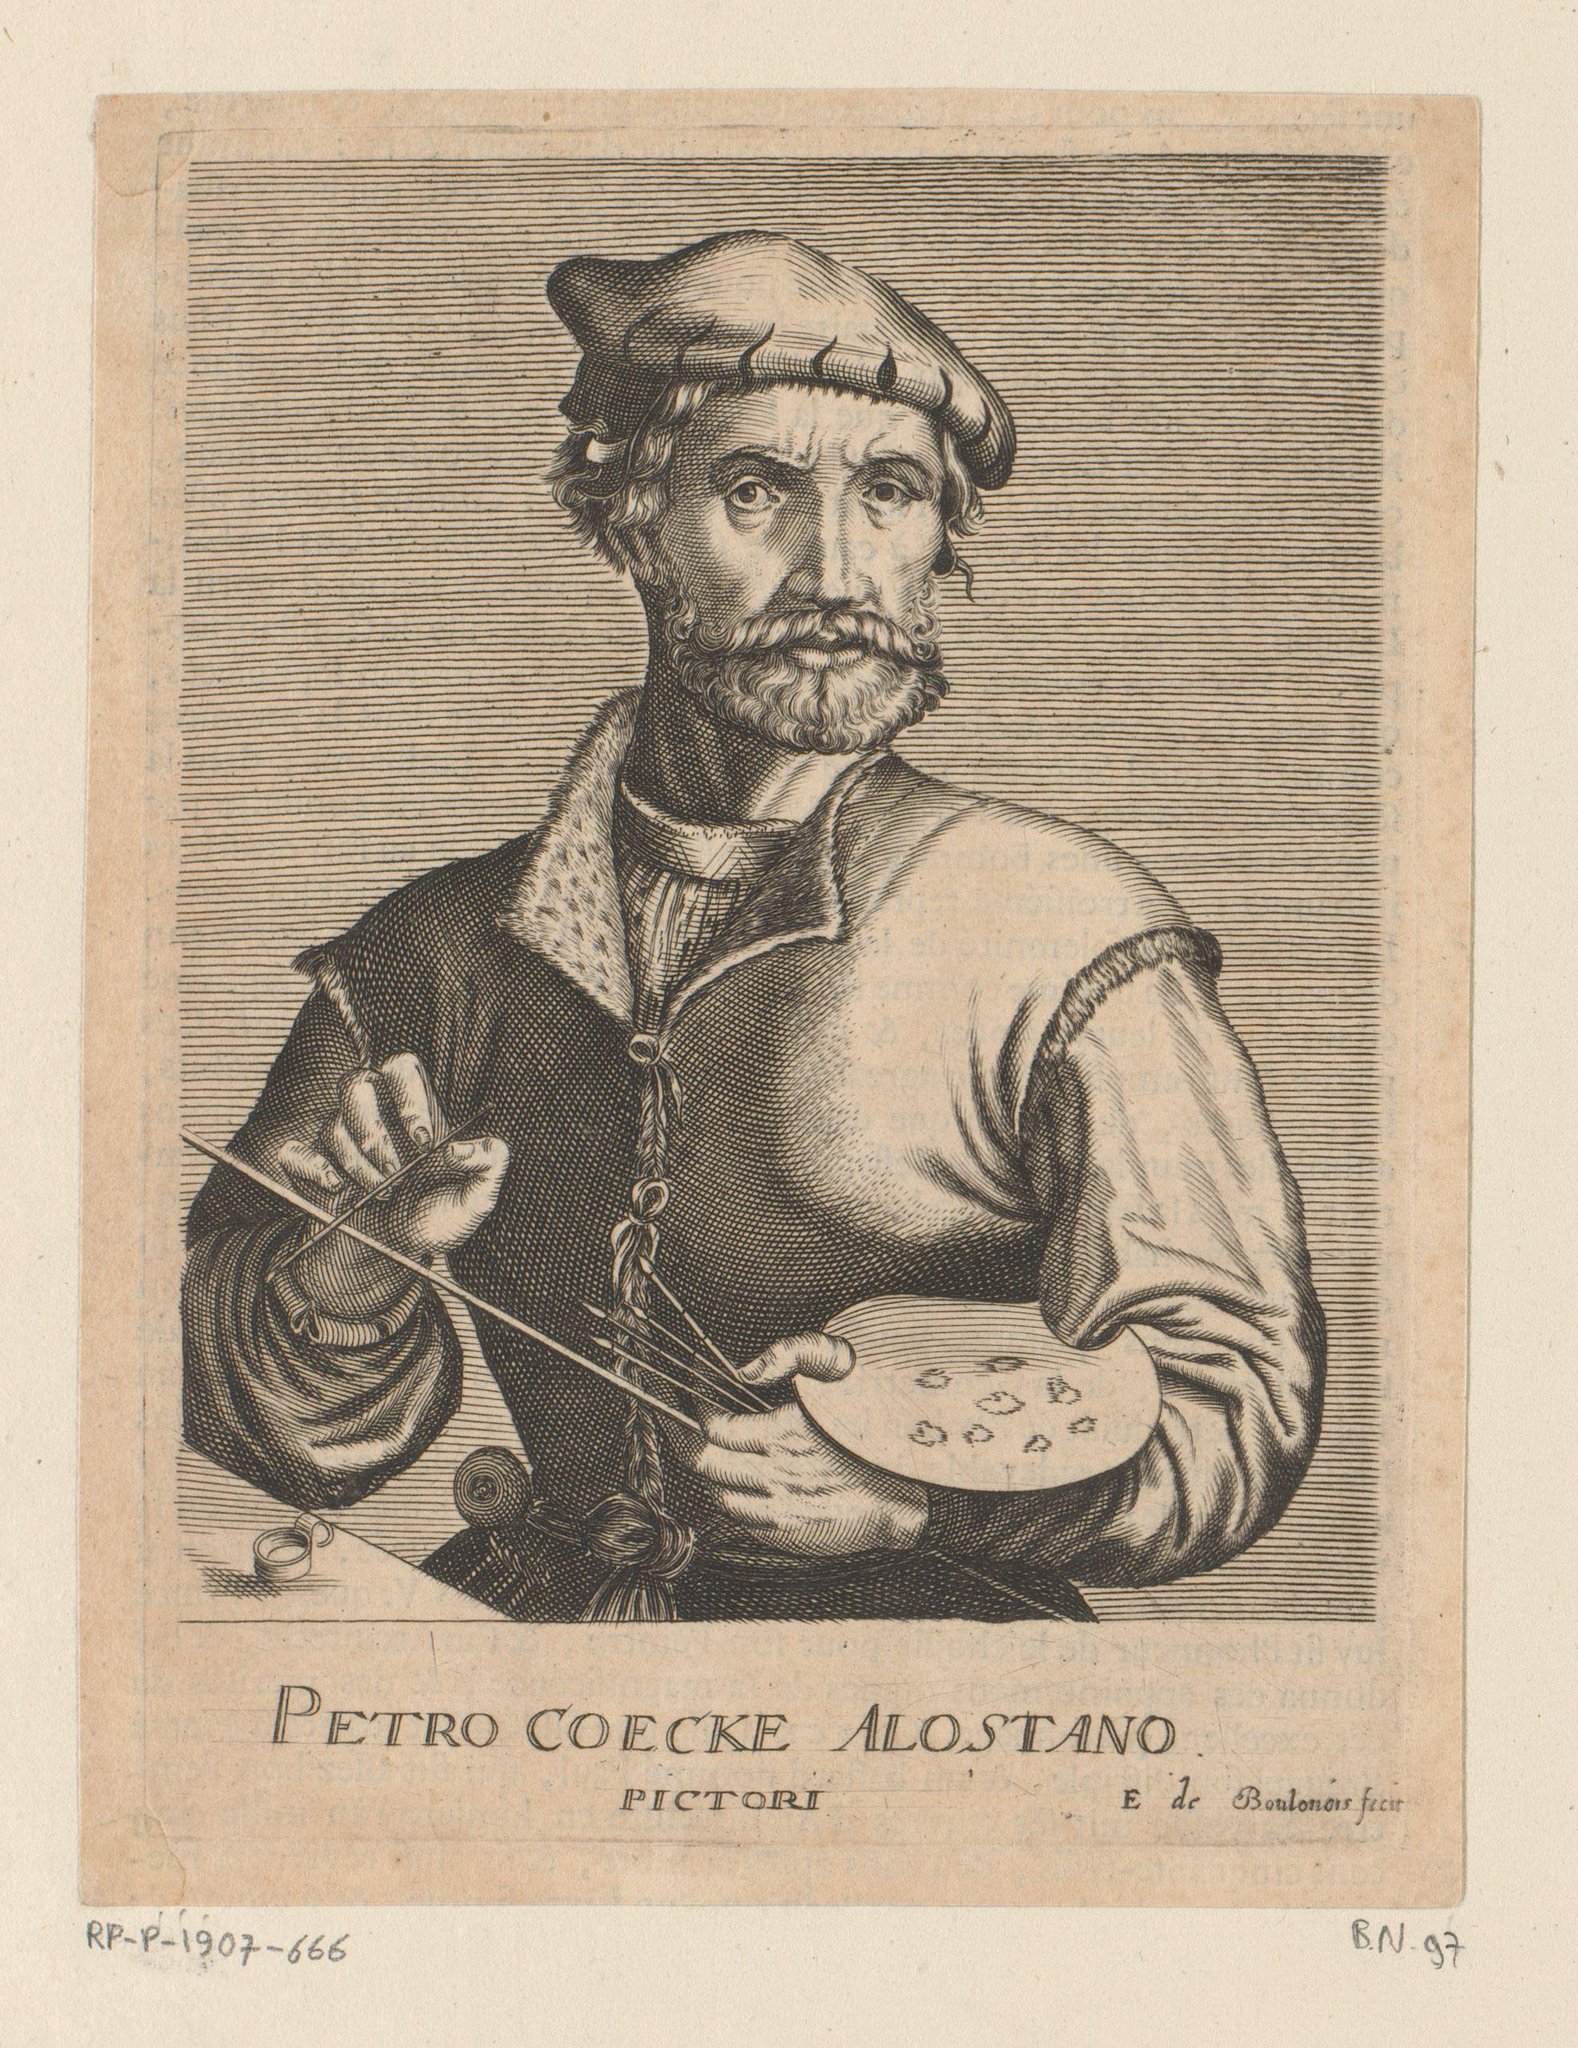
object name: book illustration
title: Petro Coecke Alostano Pictori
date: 1682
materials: paper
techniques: engraving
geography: brussels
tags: brussels, pieter coecke van aelst (i), historical persons, portrait, self-portrait of artist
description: Prent uit: Bullert, Isaac. Académie des Sciences et Arts contenant les vies et éloges his. des hommes illustres qui ont excellé en ces professions depuis environ quatre siècles. Brussel: Foppens, François, 1682. Het boek werd in 1682 eveneens in Amsterdam uitgegeven door de erfgenamen van Daniel Elzevier. Deze portretten dienen ter illustratie van de biografie van een kunstenaar of geleerde. De meeste portretten werden door Nicolas de Larmessin vervaardigd (162), 93 door De Boulonois en een derde door ongeïdentificeerde prentmakers. Dit betreft een illustratie op p. 405, deel II.